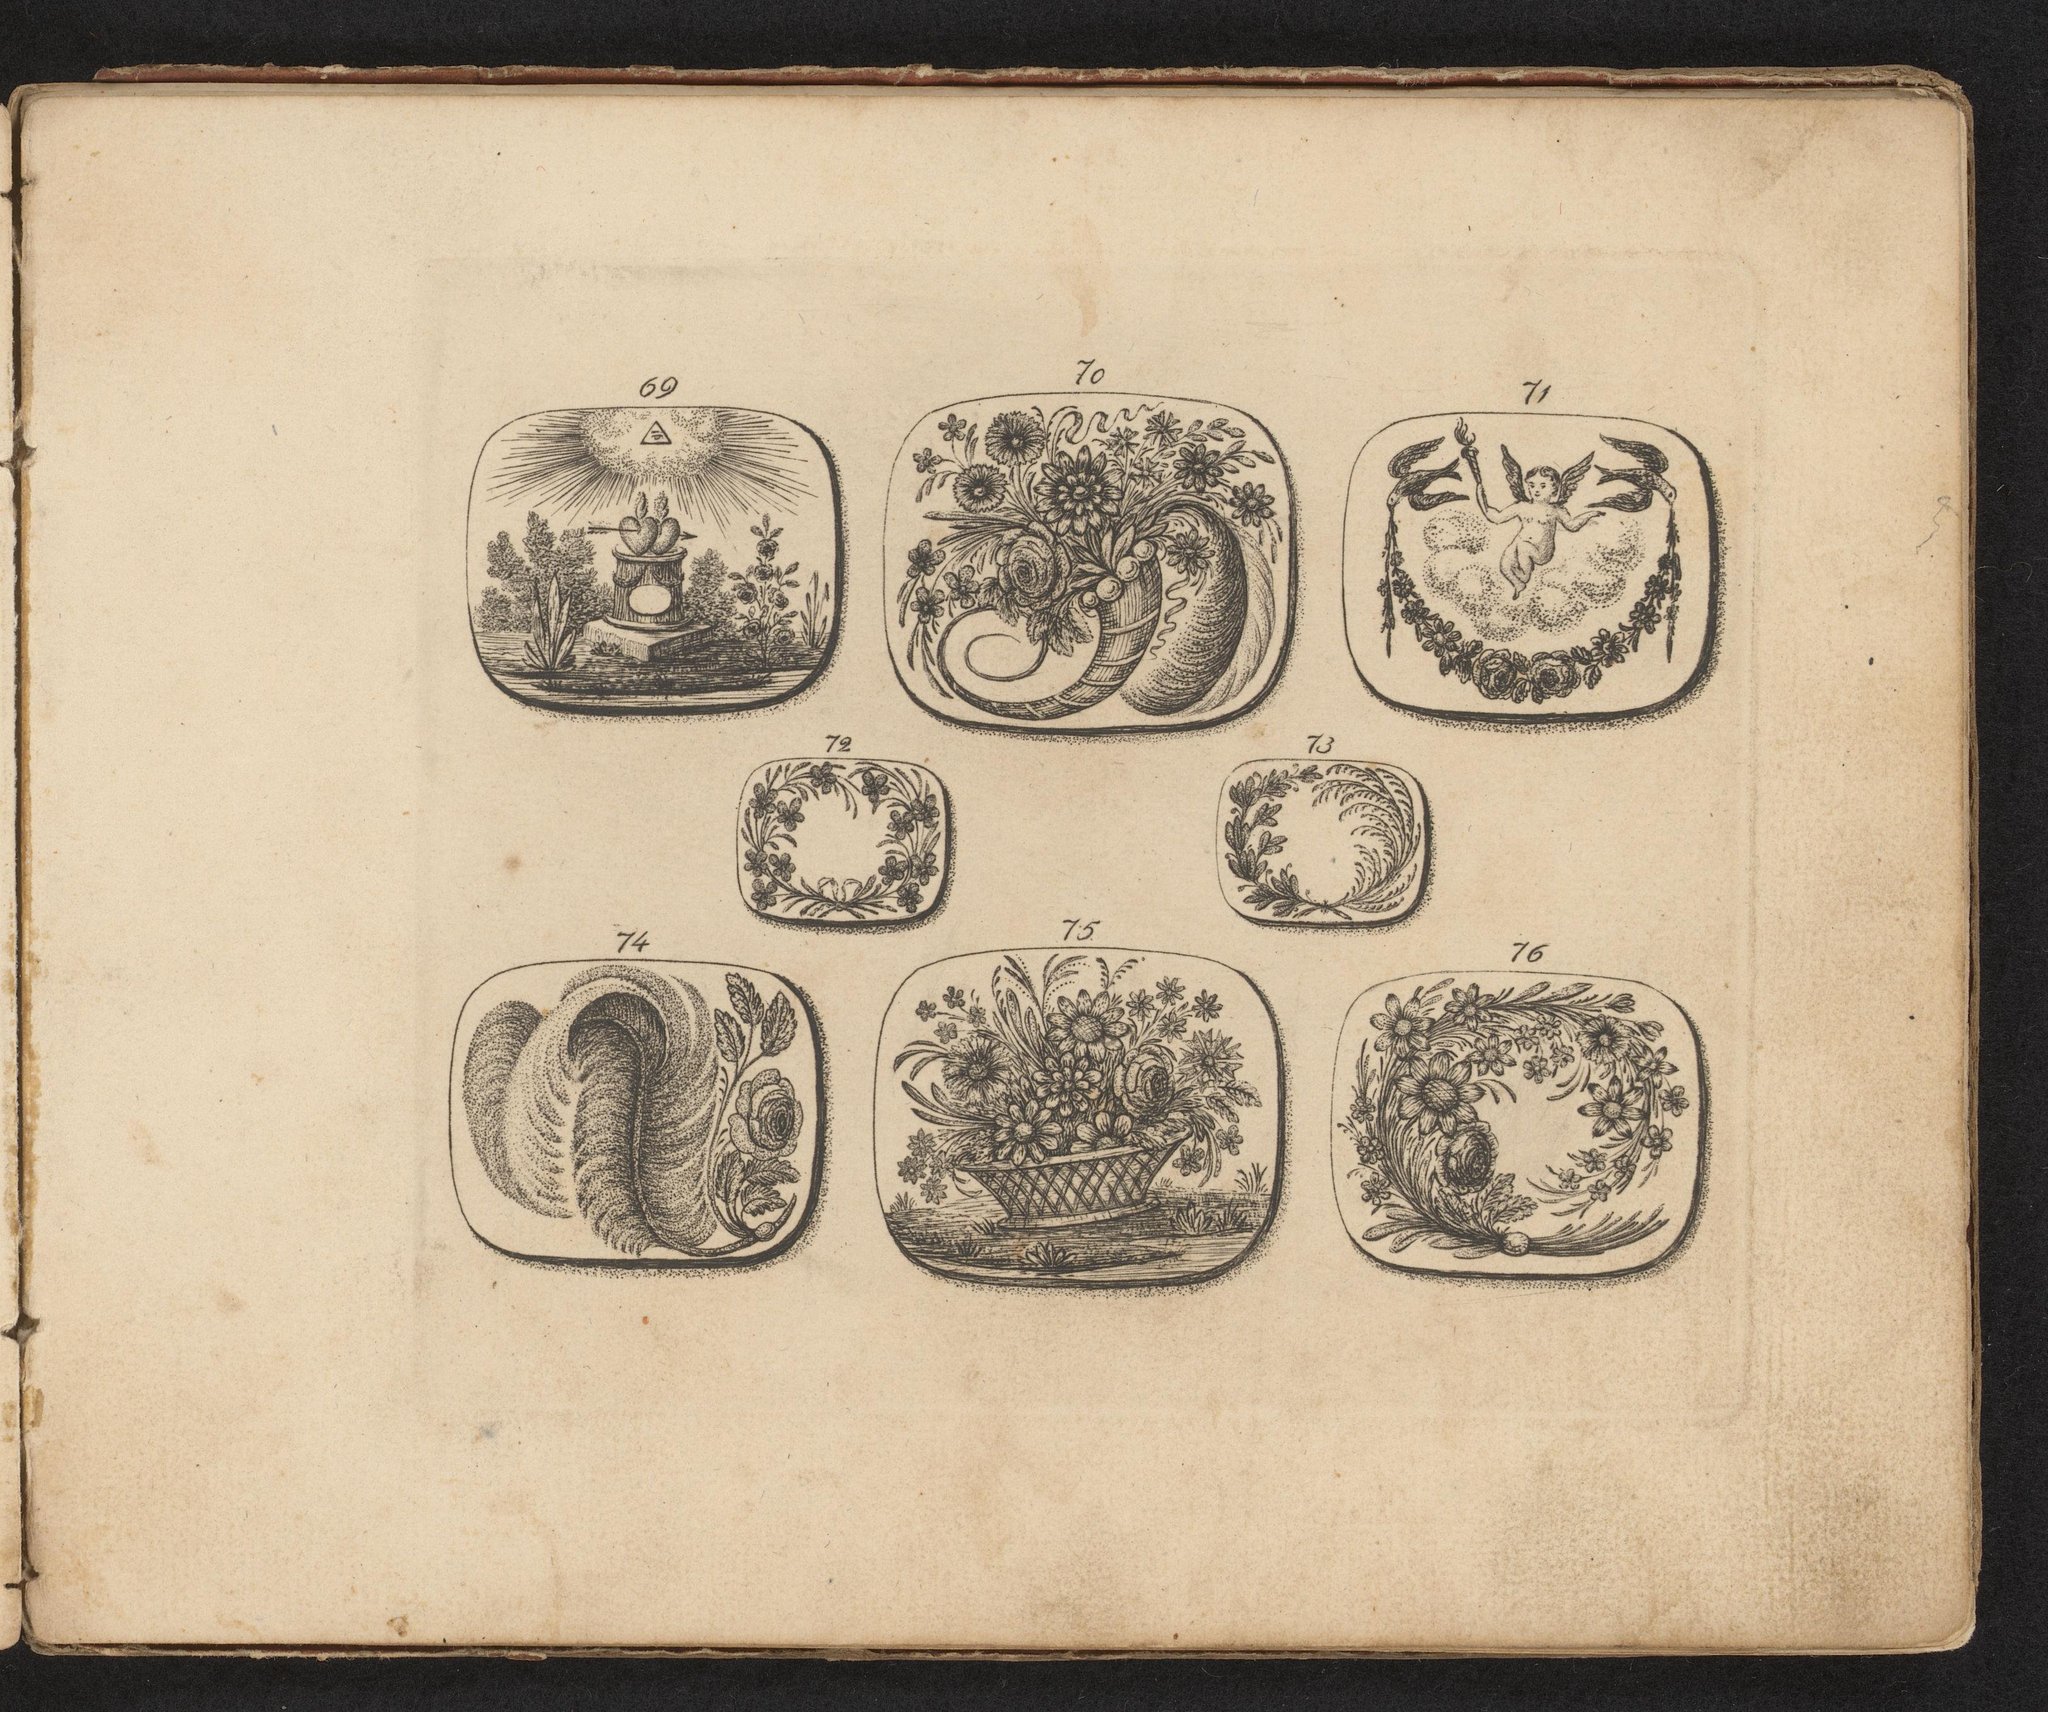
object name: album leaf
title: Acht voorbeelden van rouwsieraden met floraal motief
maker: j.d. brix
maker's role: print maker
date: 1800-1810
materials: paper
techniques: etching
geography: amsterdam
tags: ornaments, jewels, mourning customs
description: Prent met daarop voorbeelden 69 tot en met 76 van sieraden ter herinnering aan een overledene. Deze prent maakt deel uit van een album.